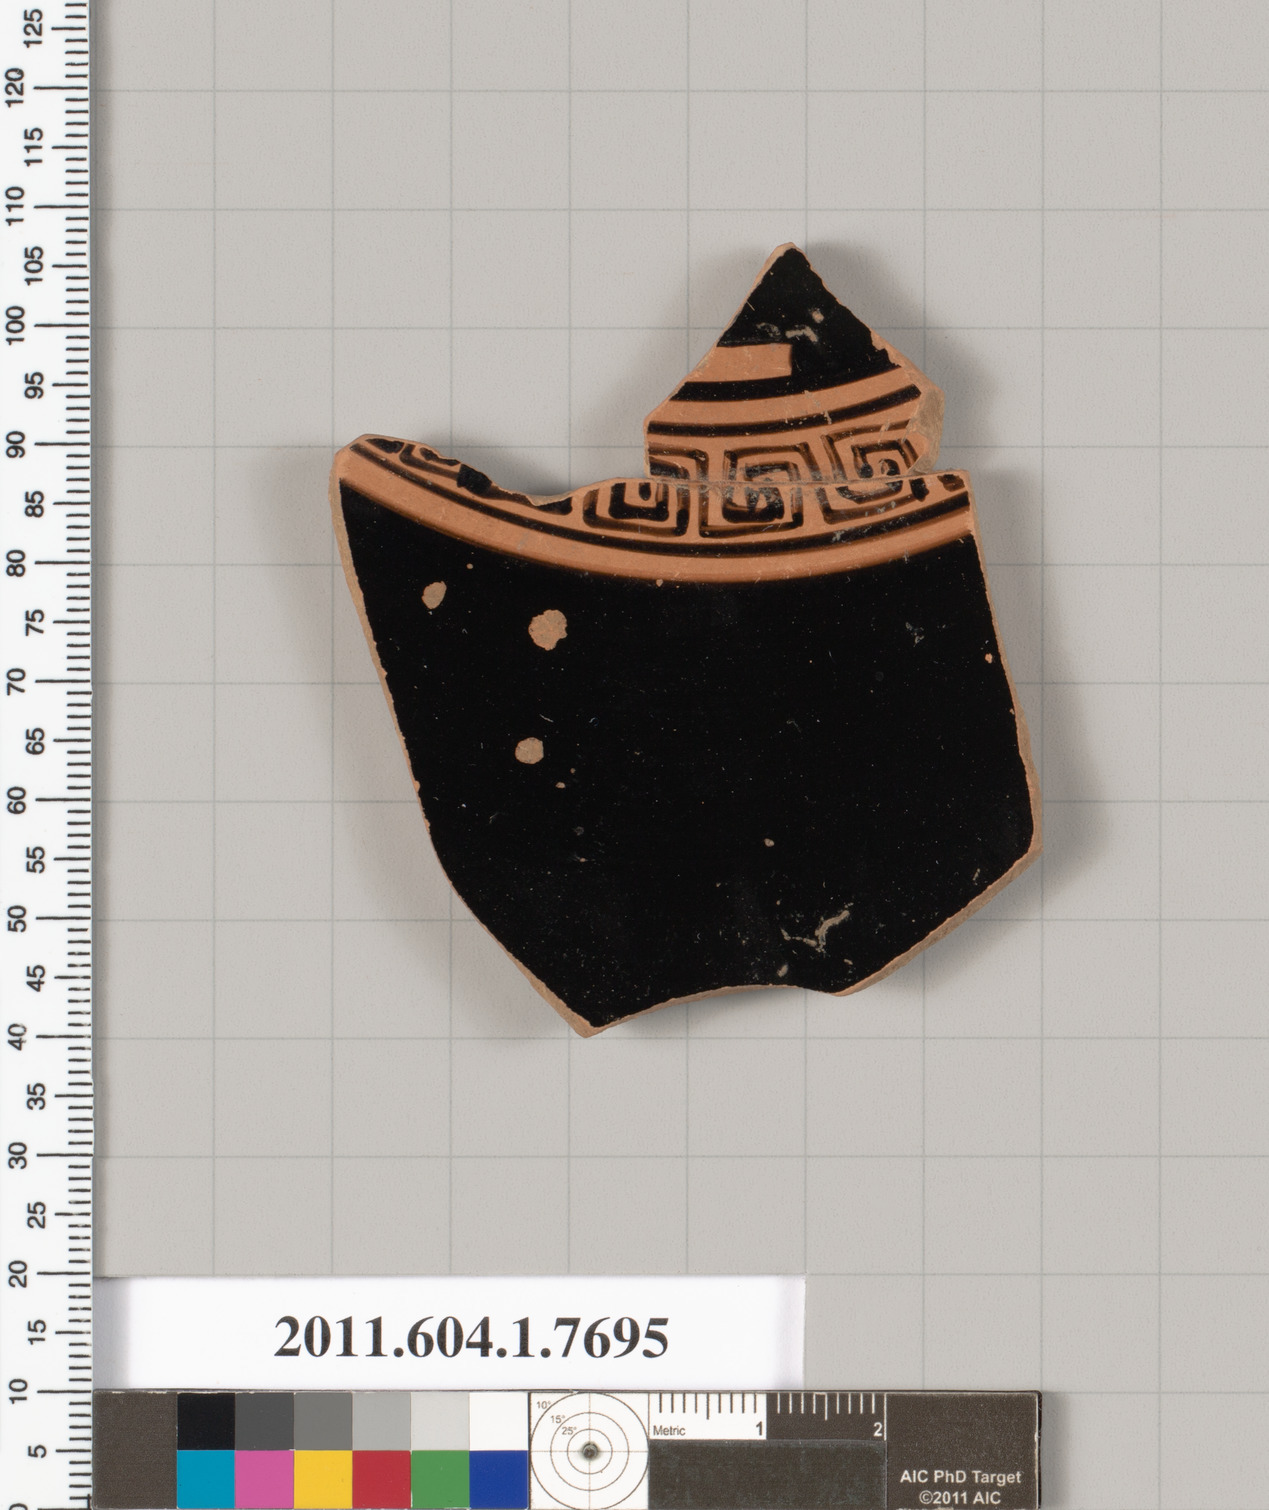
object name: kylix fragment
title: Terracotta fragment of a kylix (drinking cup)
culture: greek, attic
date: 475-451 BCE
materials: terracotta